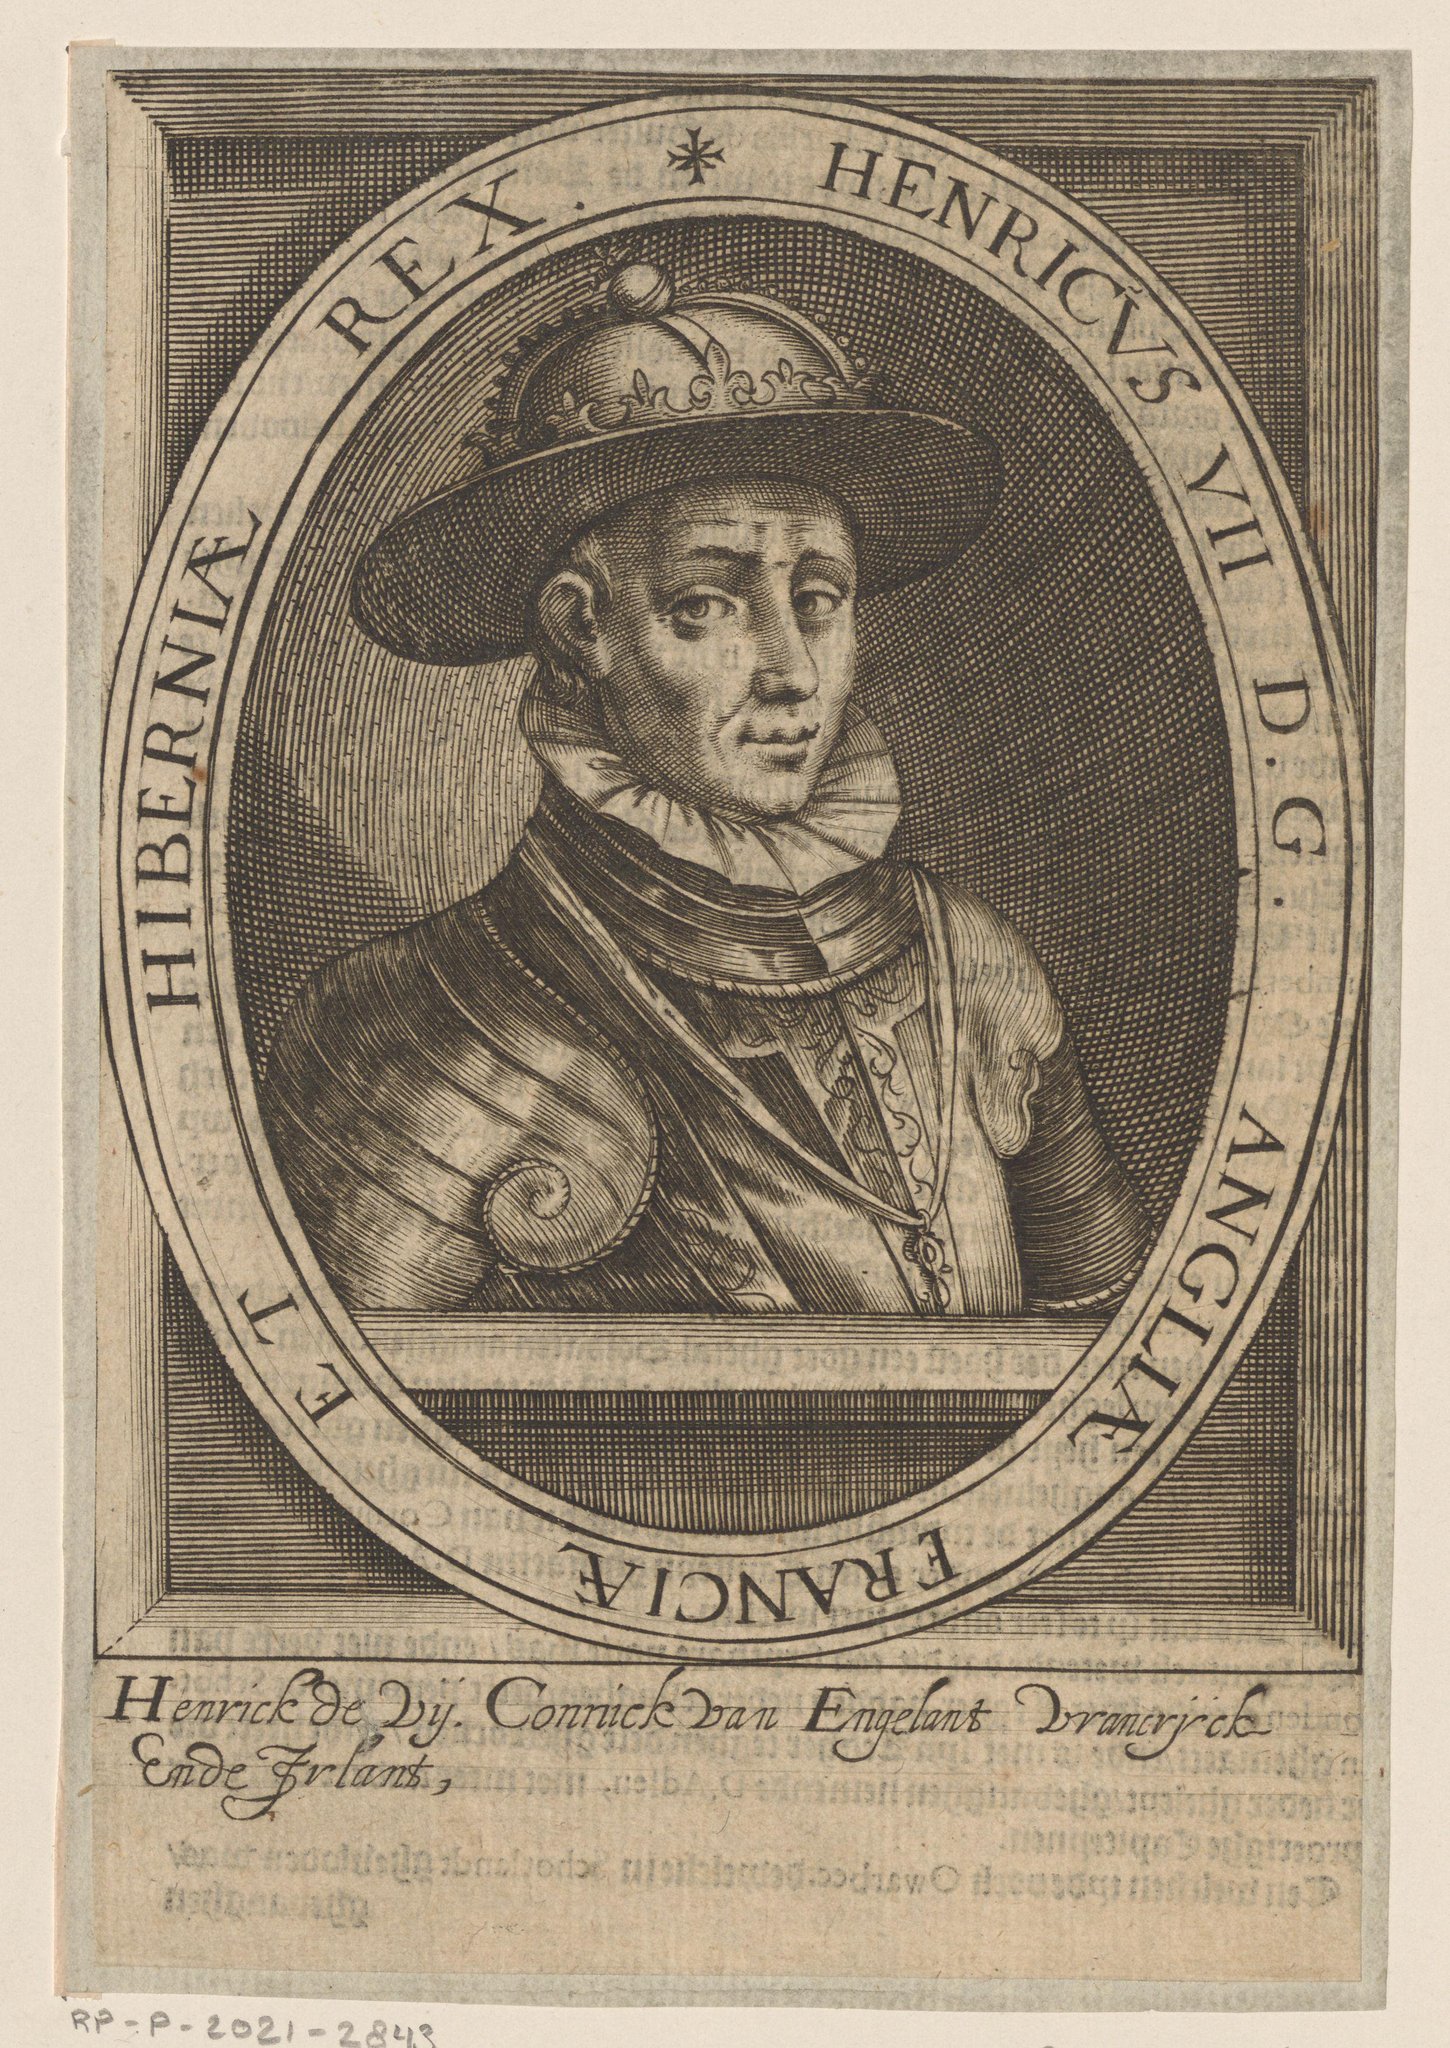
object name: book illustration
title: Portret van Hendrik VII, koning van Engeland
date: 1615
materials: paper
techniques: engraving, letterpress printing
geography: delft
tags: armour, historical persons, king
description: Prent uit: Clerck, Nicolaes de. Tooneel der keyseren en[de] coningen van christenryck sedert den onderganck van het Griecks keyserdom. Delft: Nicolaes de Clerck, 1615.